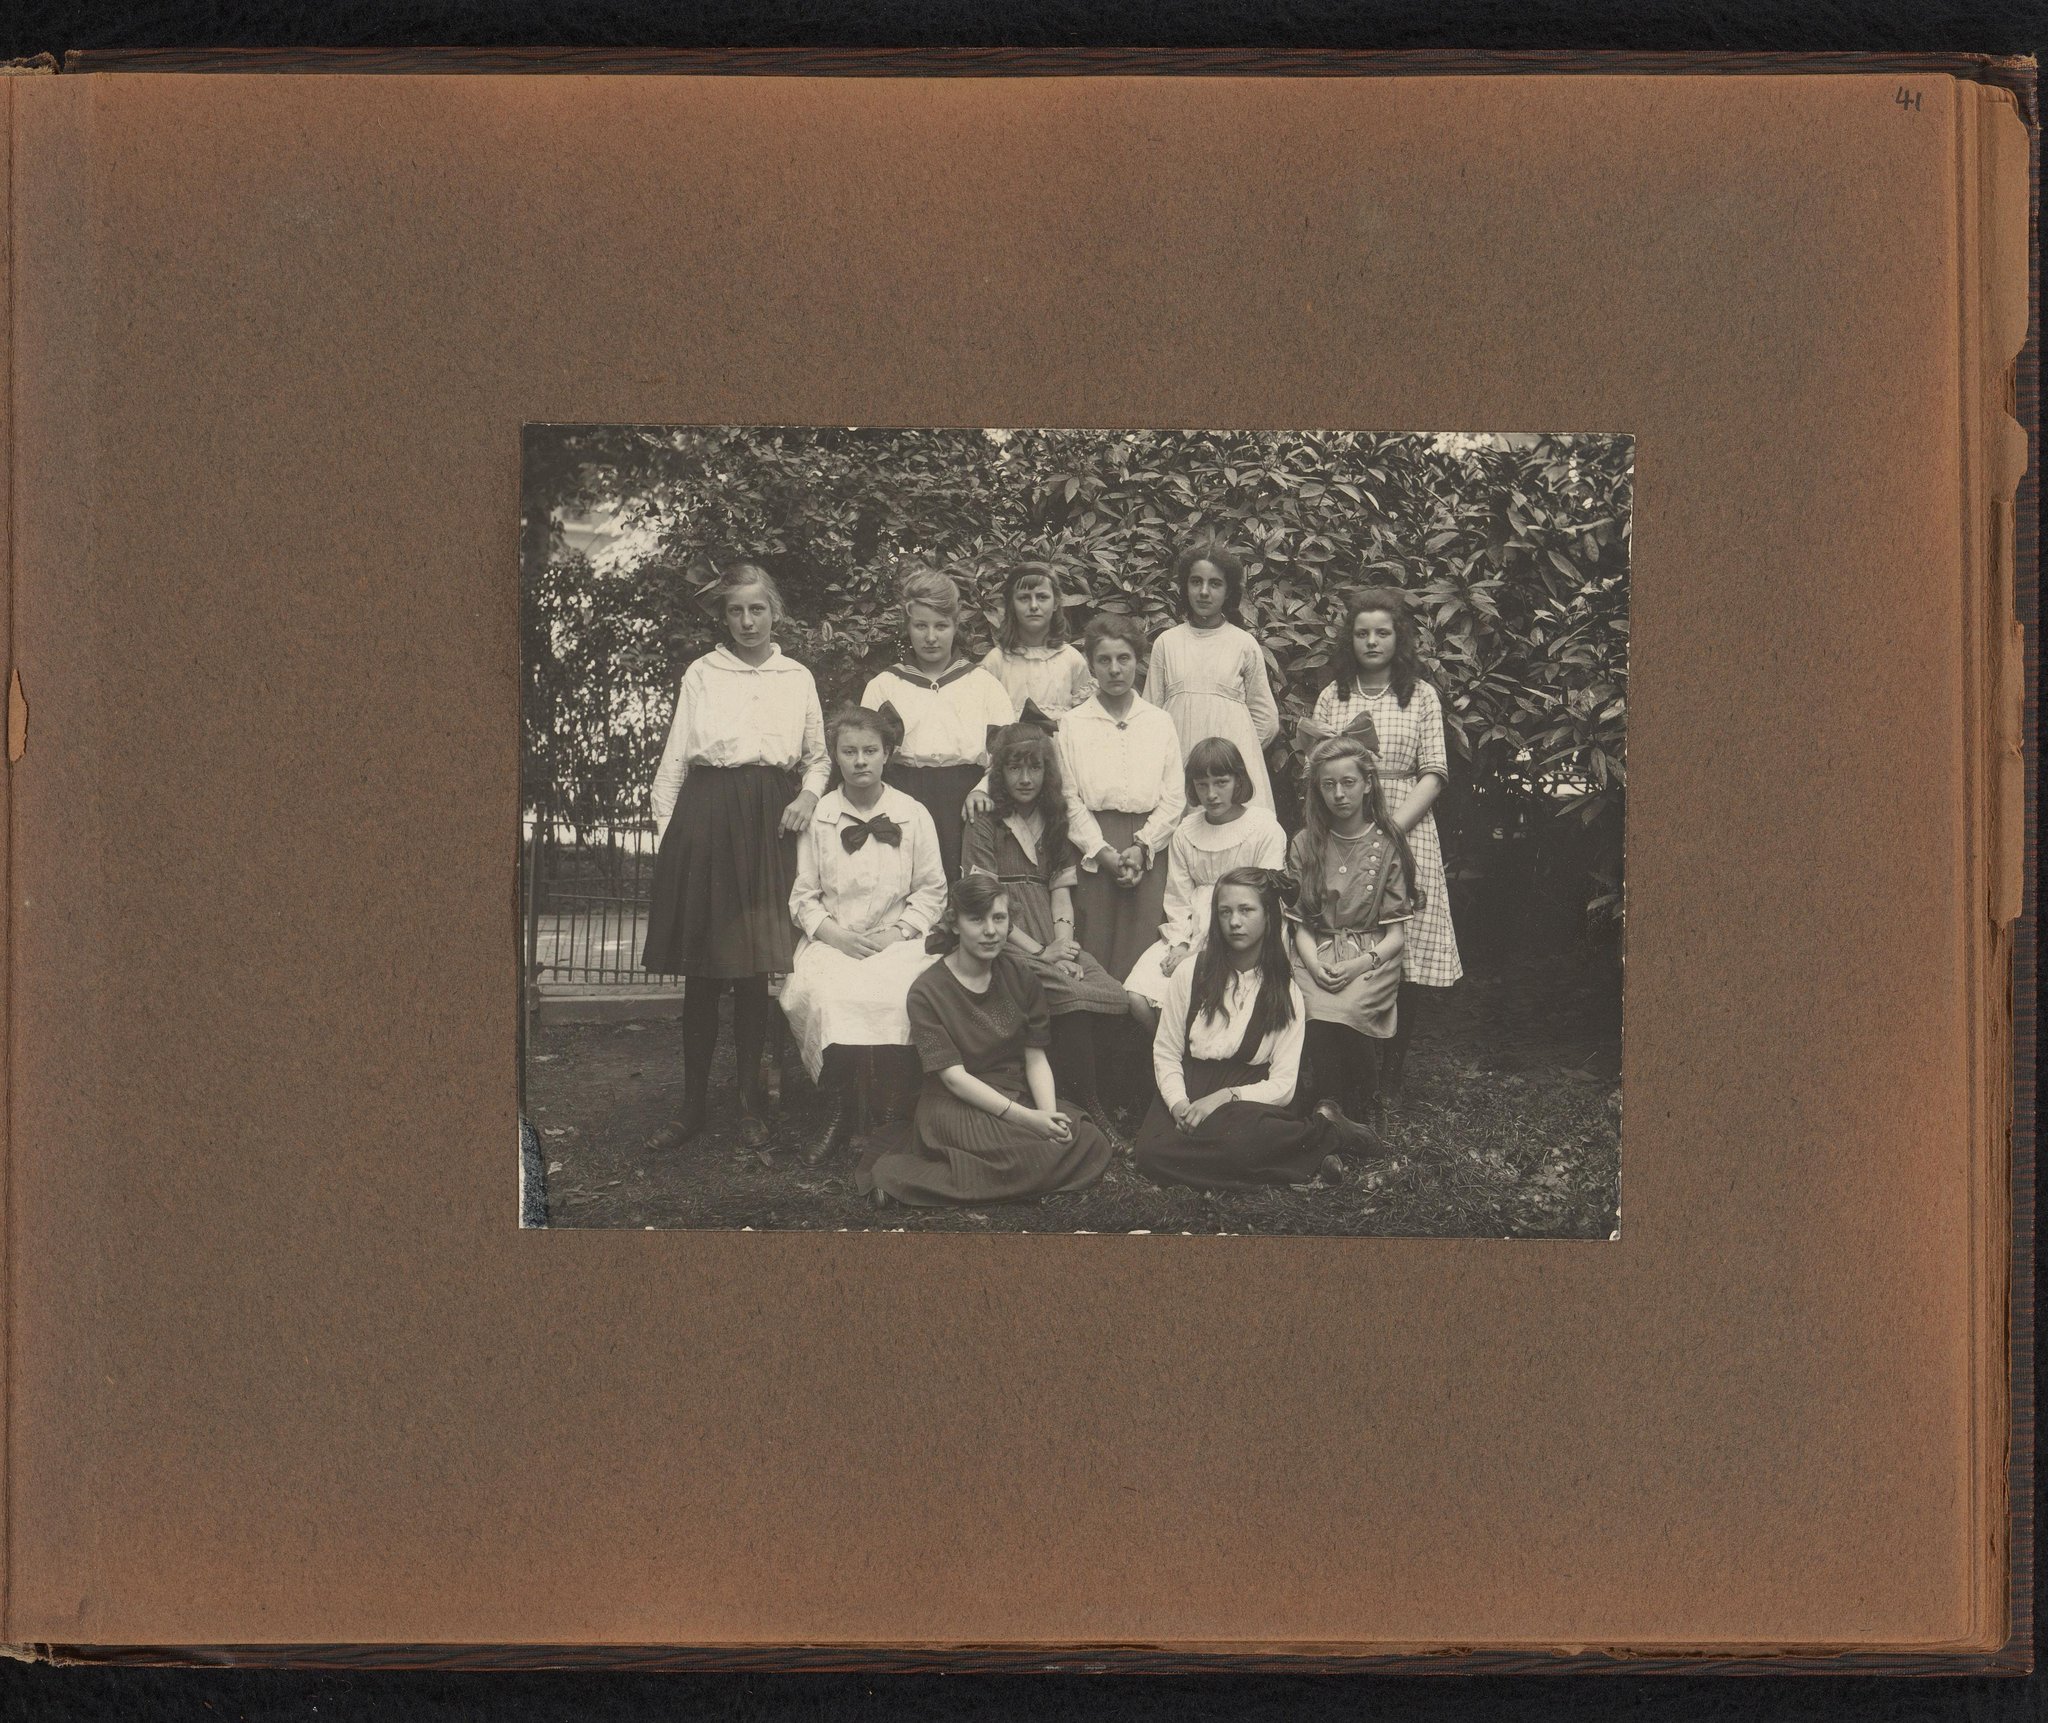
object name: album leaf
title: Bladzijde uit het fotoalbum van de familie Diepenbrock met groepsportret van jonge vrouwen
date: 1870-1920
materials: cardboard, photographic support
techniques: photography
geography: amsterdam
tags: netherlands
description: Bruin albumblad 41 van familiealbum van Alphons Diepenbrock.